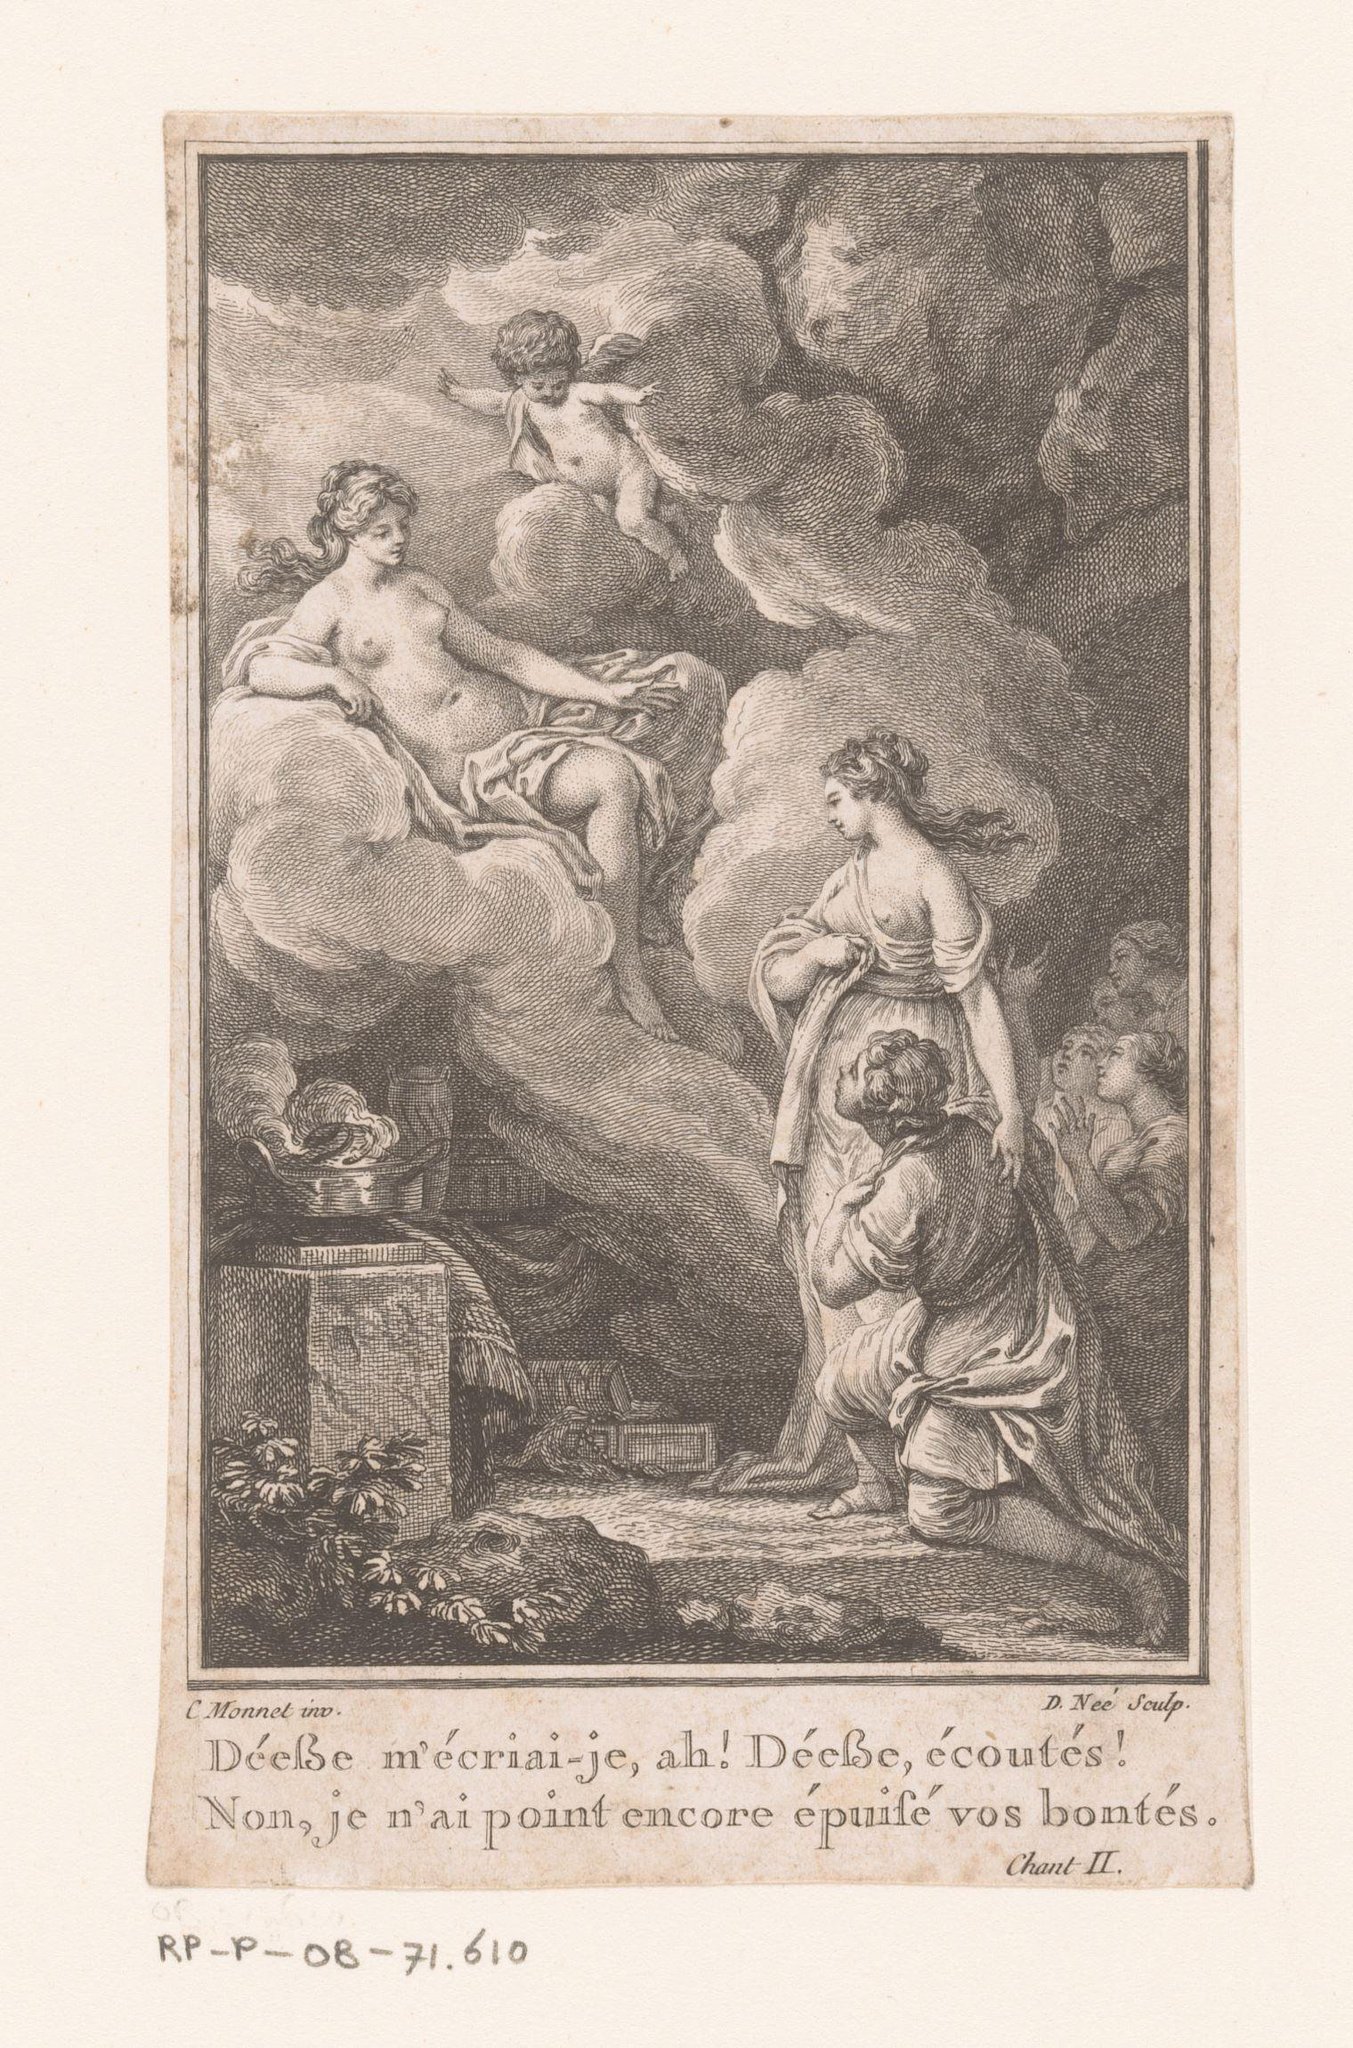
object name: book illustration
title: Figuren voor een altaar waaraan een godin verschijnt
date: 1749-1817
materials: paper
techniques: engraving, etching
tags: altar ~ non-christian religions, sacrifice ~ roman religion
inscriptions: collector's mark: Lugt 2228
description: Mogelijk prent uit een editie van 'De la philosophie de la nature', door Delisle de Sales.